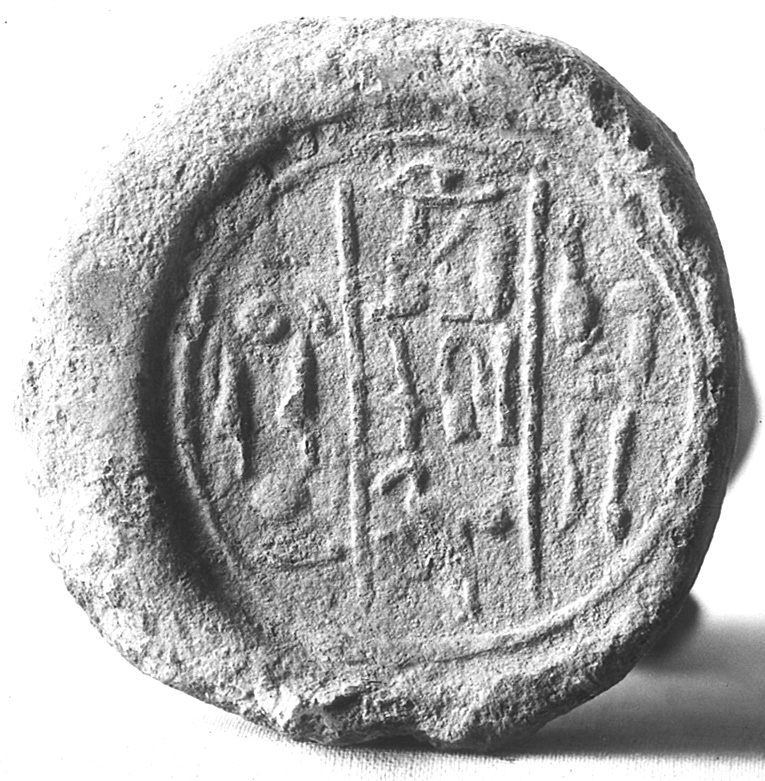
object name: cone, circular impression, djehutynefer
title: Funerary Cone of Djehutynefer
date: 1550-1352 BCE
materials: pottery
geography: egypt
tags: hieroglyphs